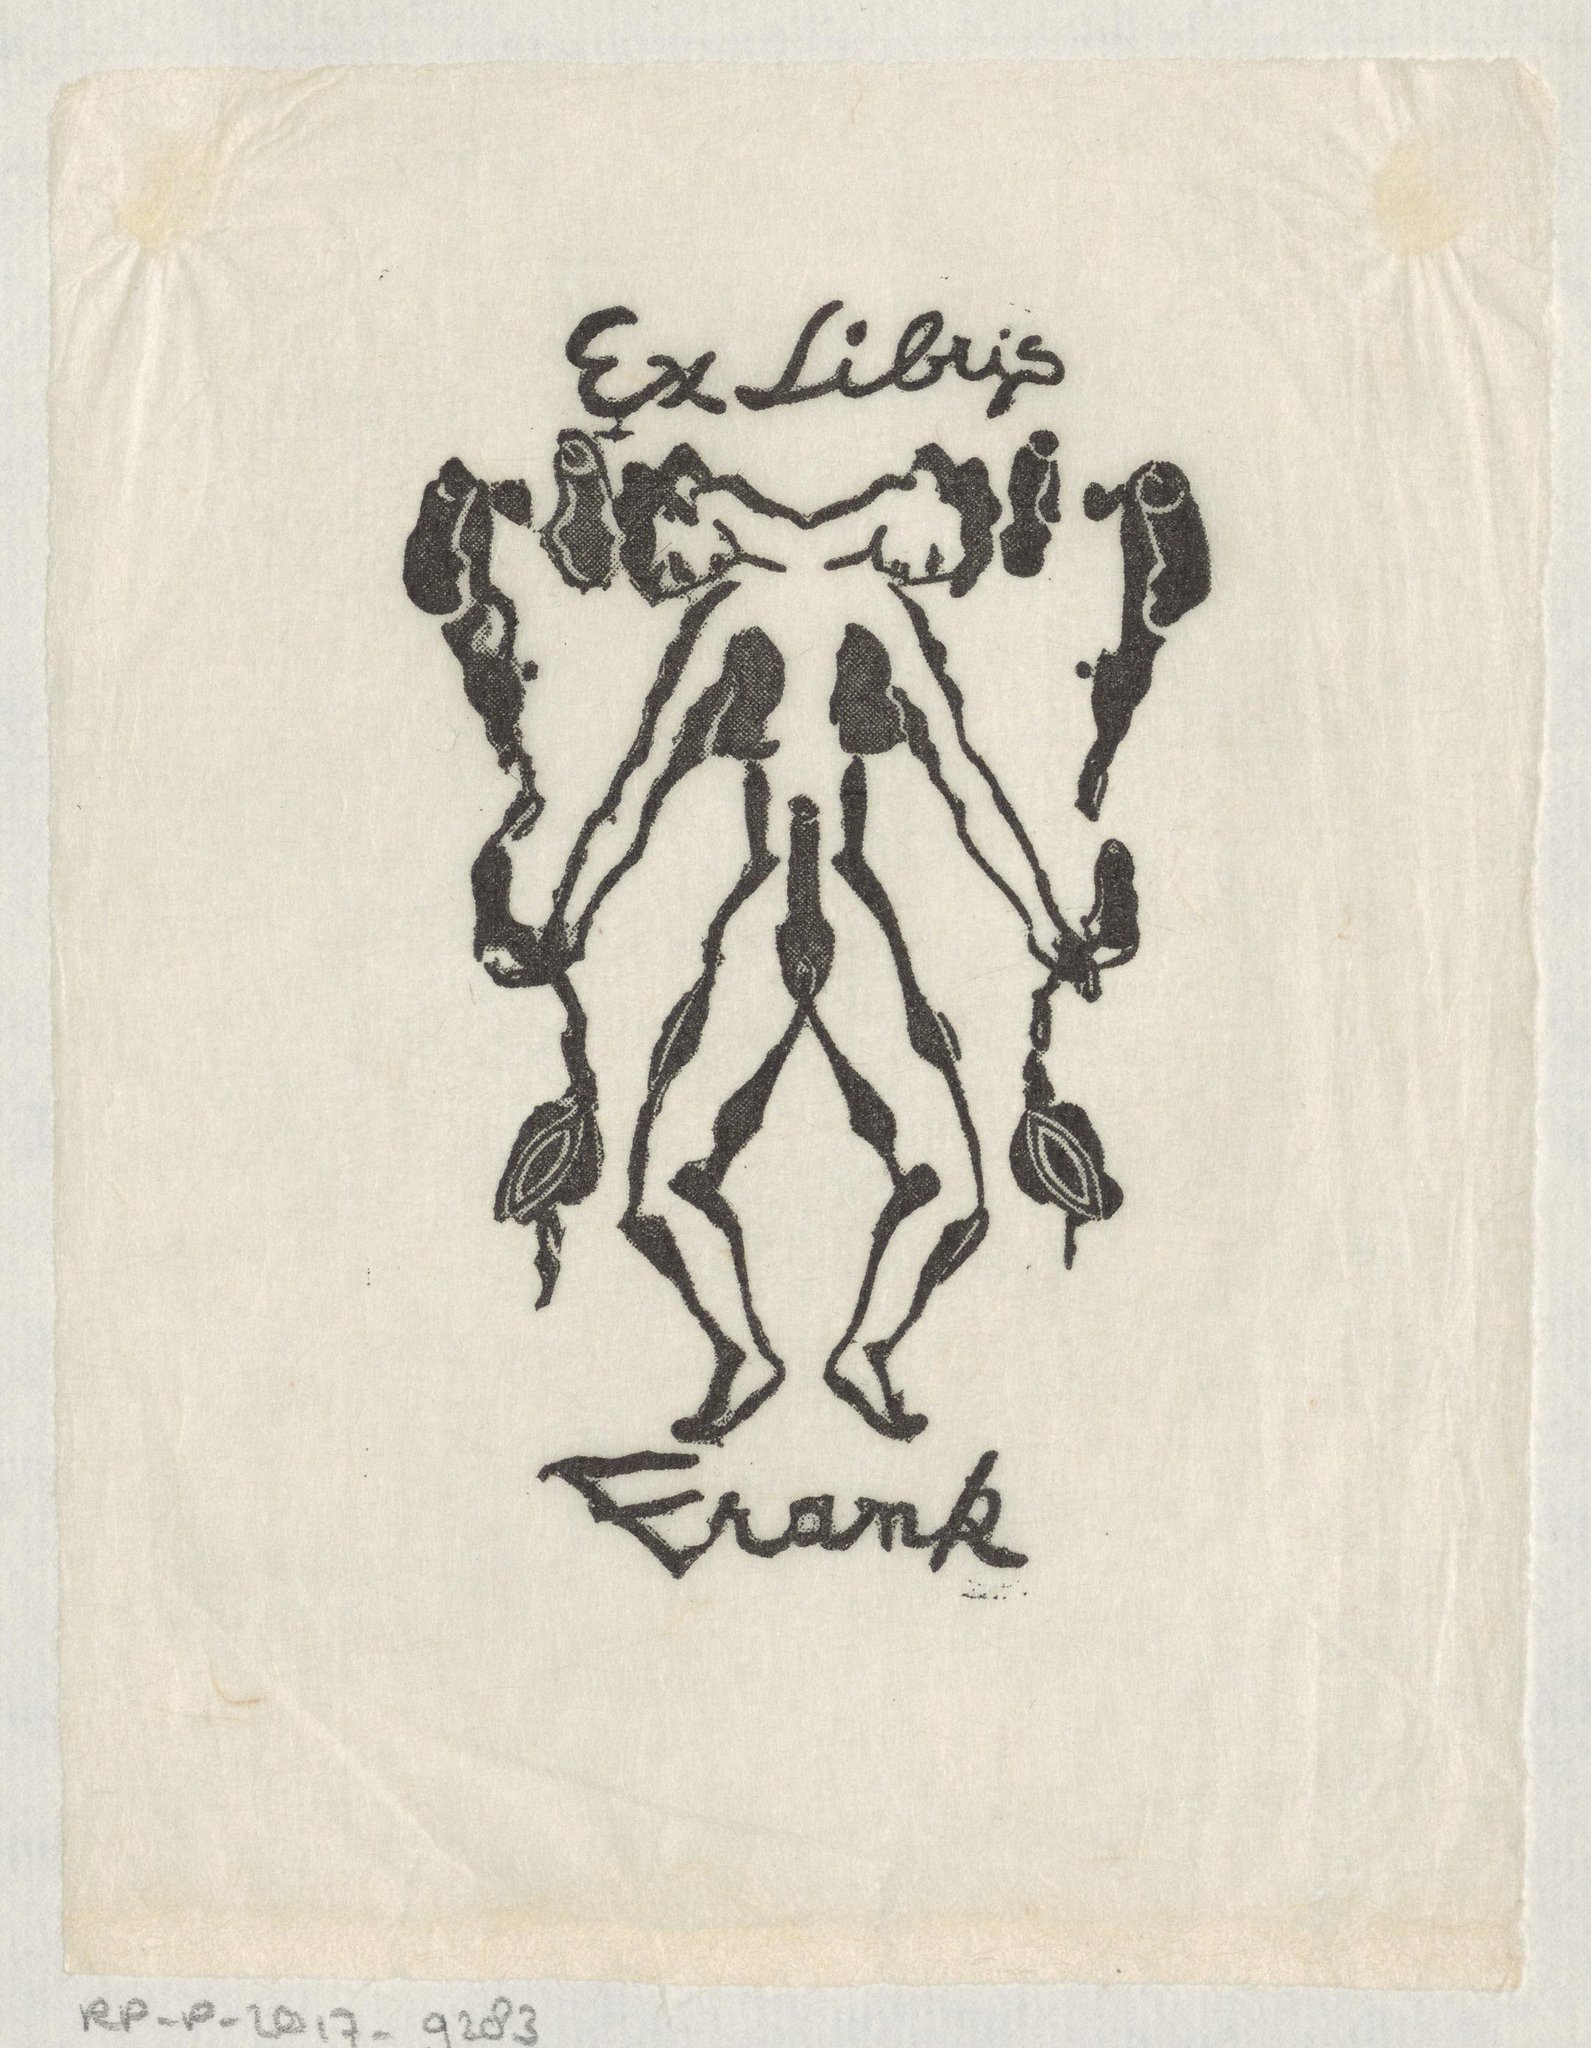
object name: bookplate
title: Ex libris van Frank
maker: Anonymous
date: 1900-1999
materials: paper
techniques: printing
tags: man (showing himself) undressed, quasi-nude